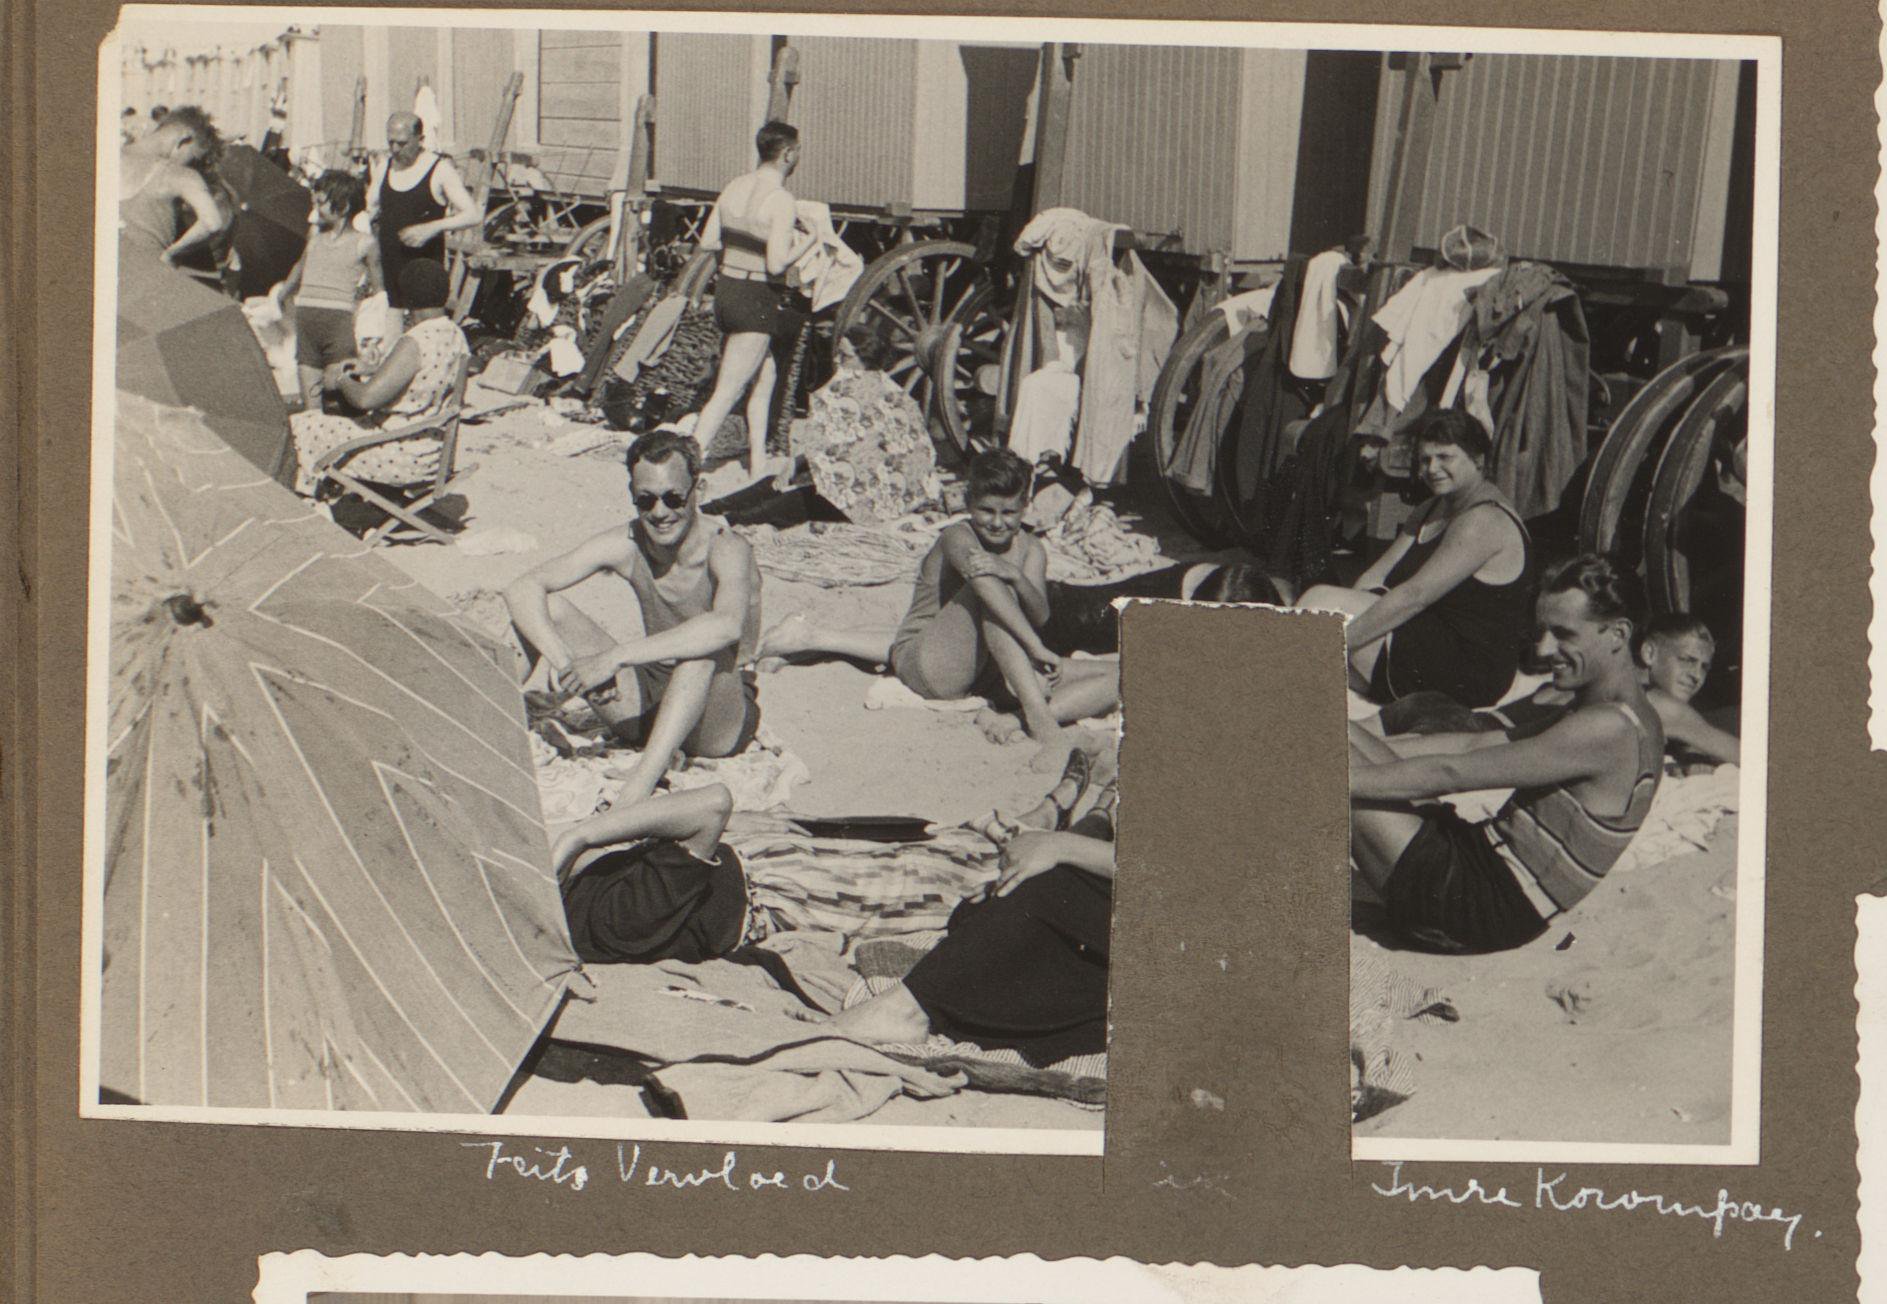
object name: photograph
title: Gezelschap op het strand van Scheveningen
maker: Anonymous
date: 1932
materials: paper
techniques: gelatin silver print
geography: scheveningen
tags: sunbathing (on the beach)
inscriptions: inscription: ‘Frits Vervloed/ Imre Korompay’